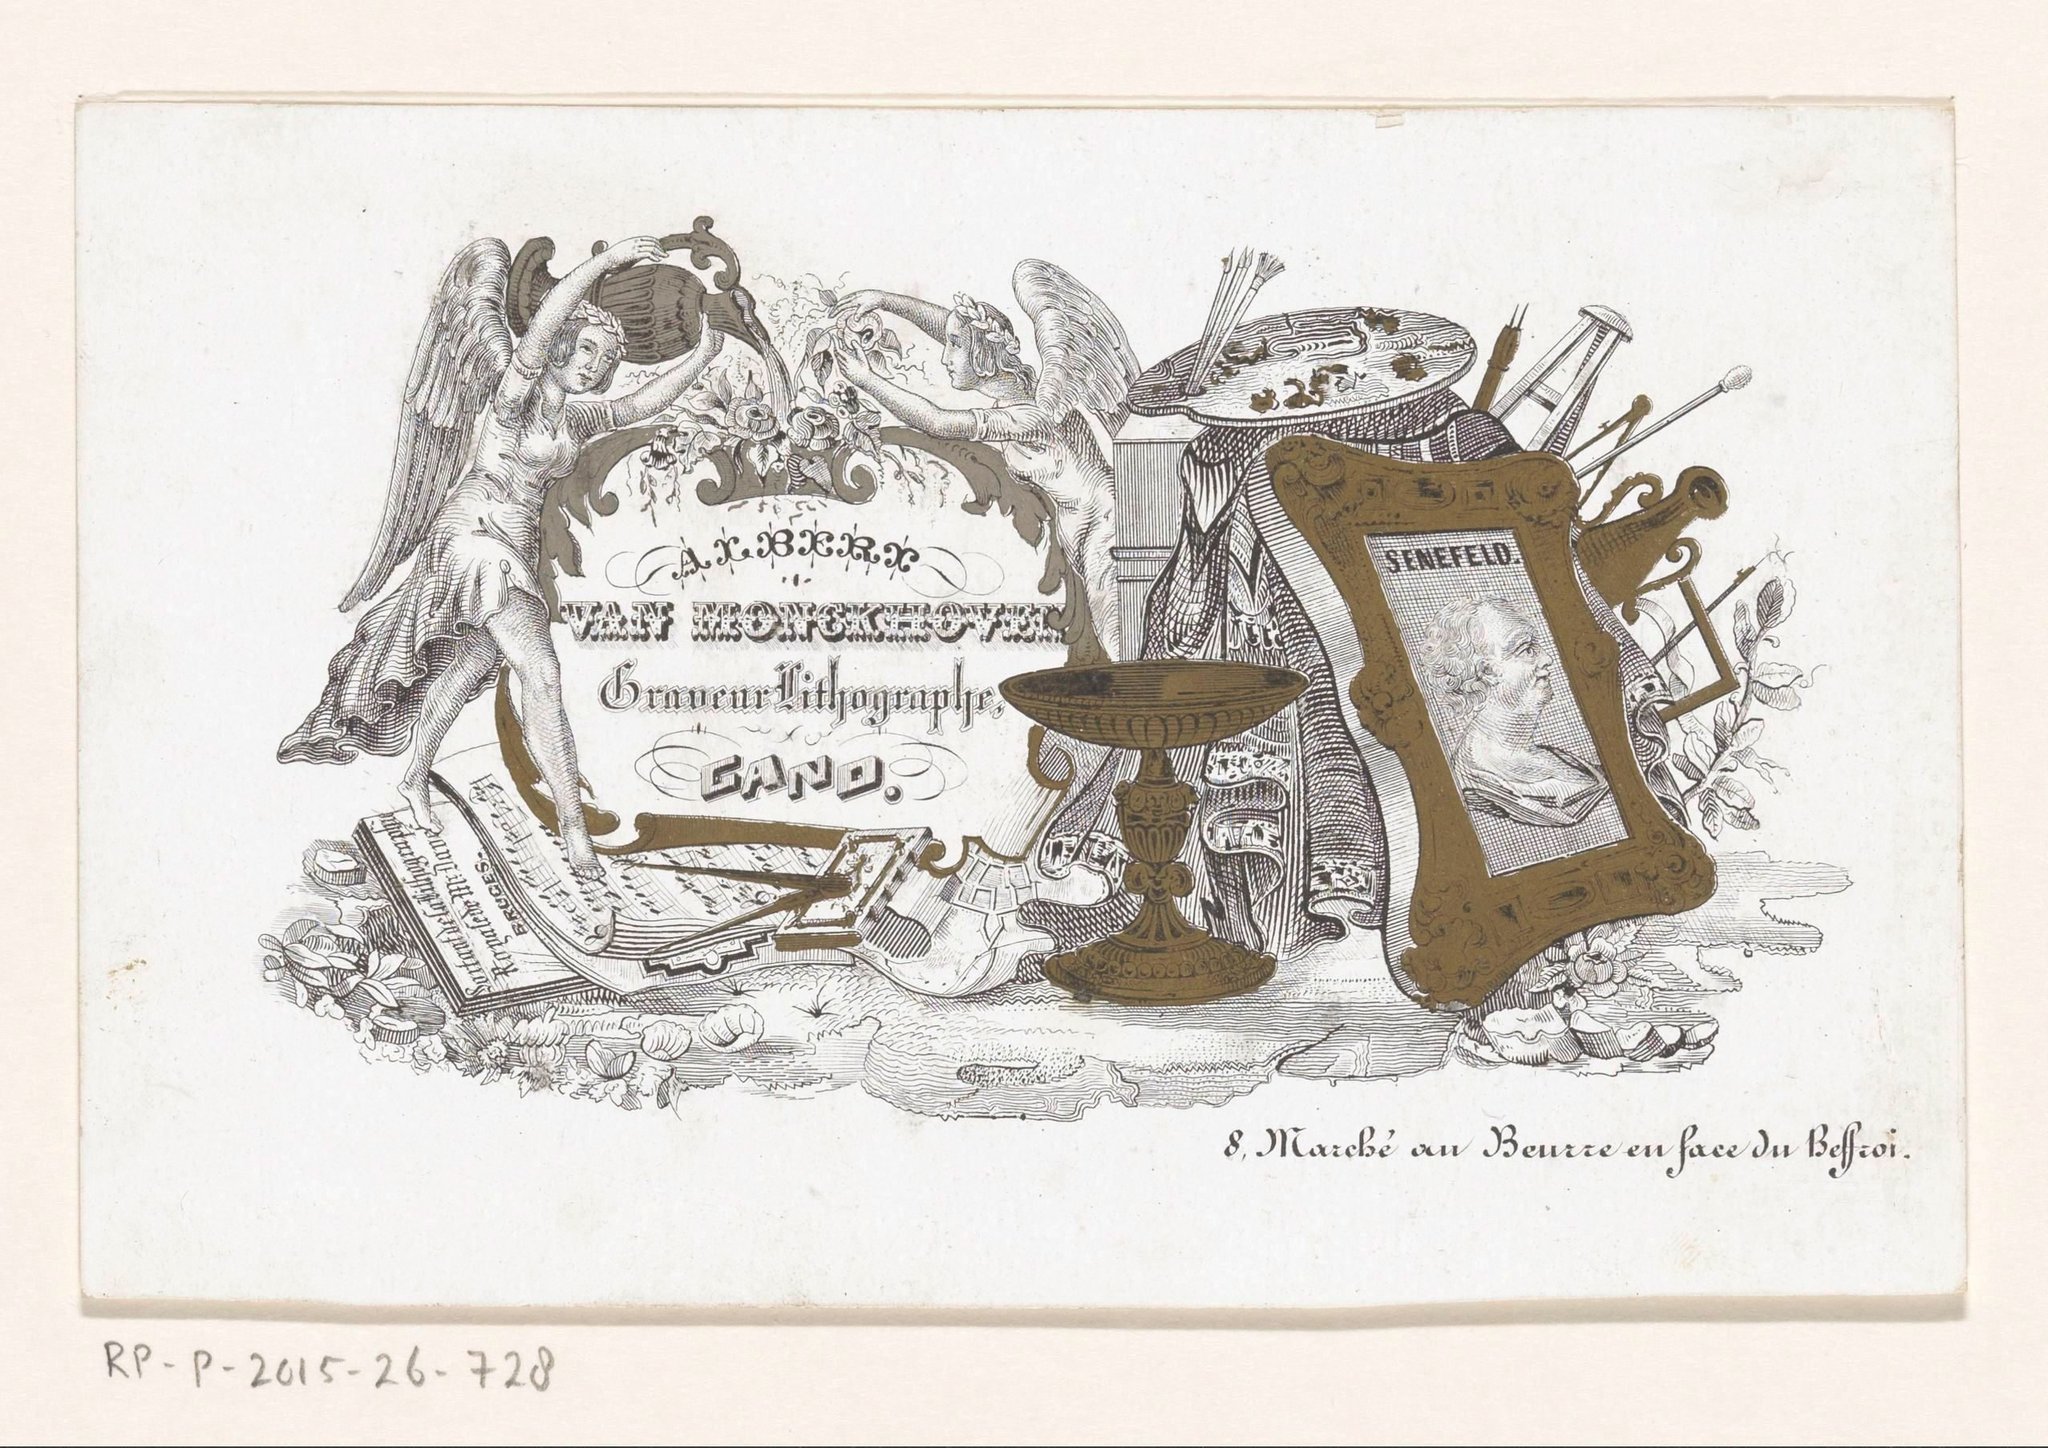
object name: print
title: Visitekaartje van lithograaf Albert van Monckhoven te Gent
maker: albert van monckhoven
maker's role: print maker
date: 1842-1875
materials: porcelainized cardboard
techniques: lithograph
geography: ghent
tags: prague, print maker, printer, alois senefelder, tools, implements of painter, angels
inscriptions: collector's mark, collector's mark: Lugt 2228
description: Twee engelen verzorgen bloemen die op het cartouche met de naam van de lithograaf groeien. Rechts een portret van Alois Senefelder, omgeven door kunstenaarsattributen.